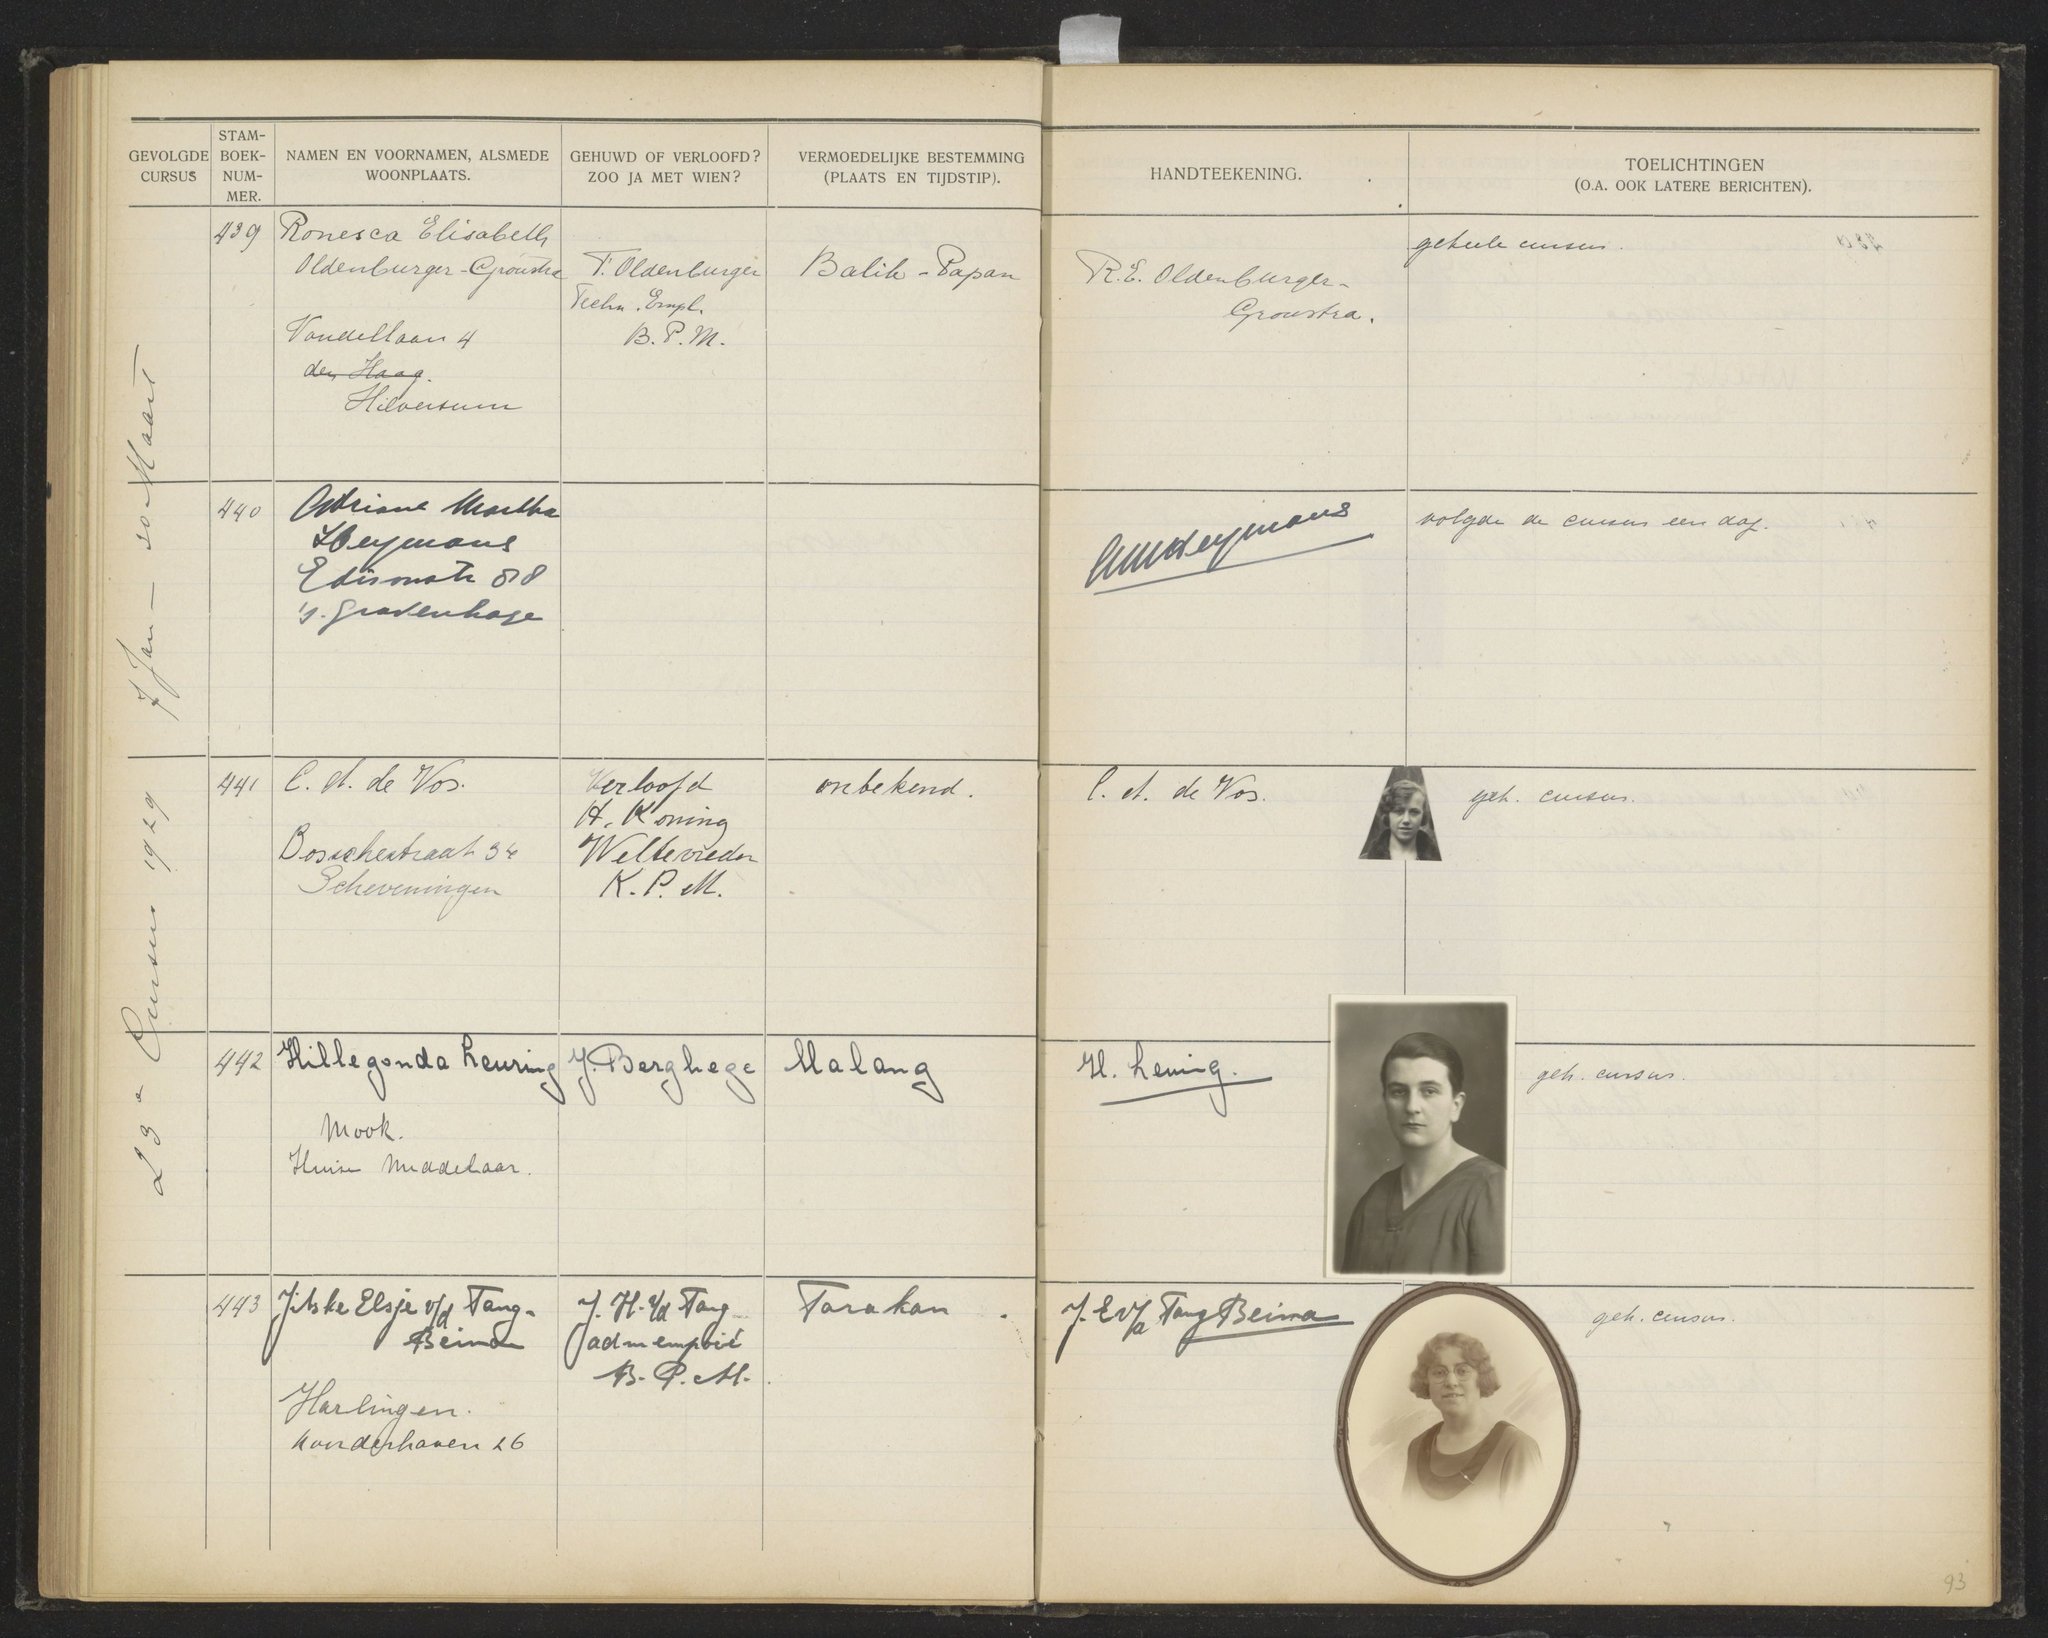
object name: photograph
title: Blad 93 uit Stamboek van de leerlingen der Koloniale School voor Meisjes en Vrouwen te 's-Gravenhage deel I (1921-1929)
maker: Anonymous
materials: paper, photographic support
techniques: photography, printing, writing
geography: the hague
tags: further education (+ pupil), further education, the hague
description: Twee pagina's met gegevens van de deelnemers aan de 23e driemaandelijkse cursus van 7 januari tot en met 30 maart 1929, stamboeknummers 439 tot en met 443. Onderdeel van Stamboek van de leerlingen der Koloniale School voor Meisjes en Vrouwen te 's-Gravenhage deel I (1921-1929).